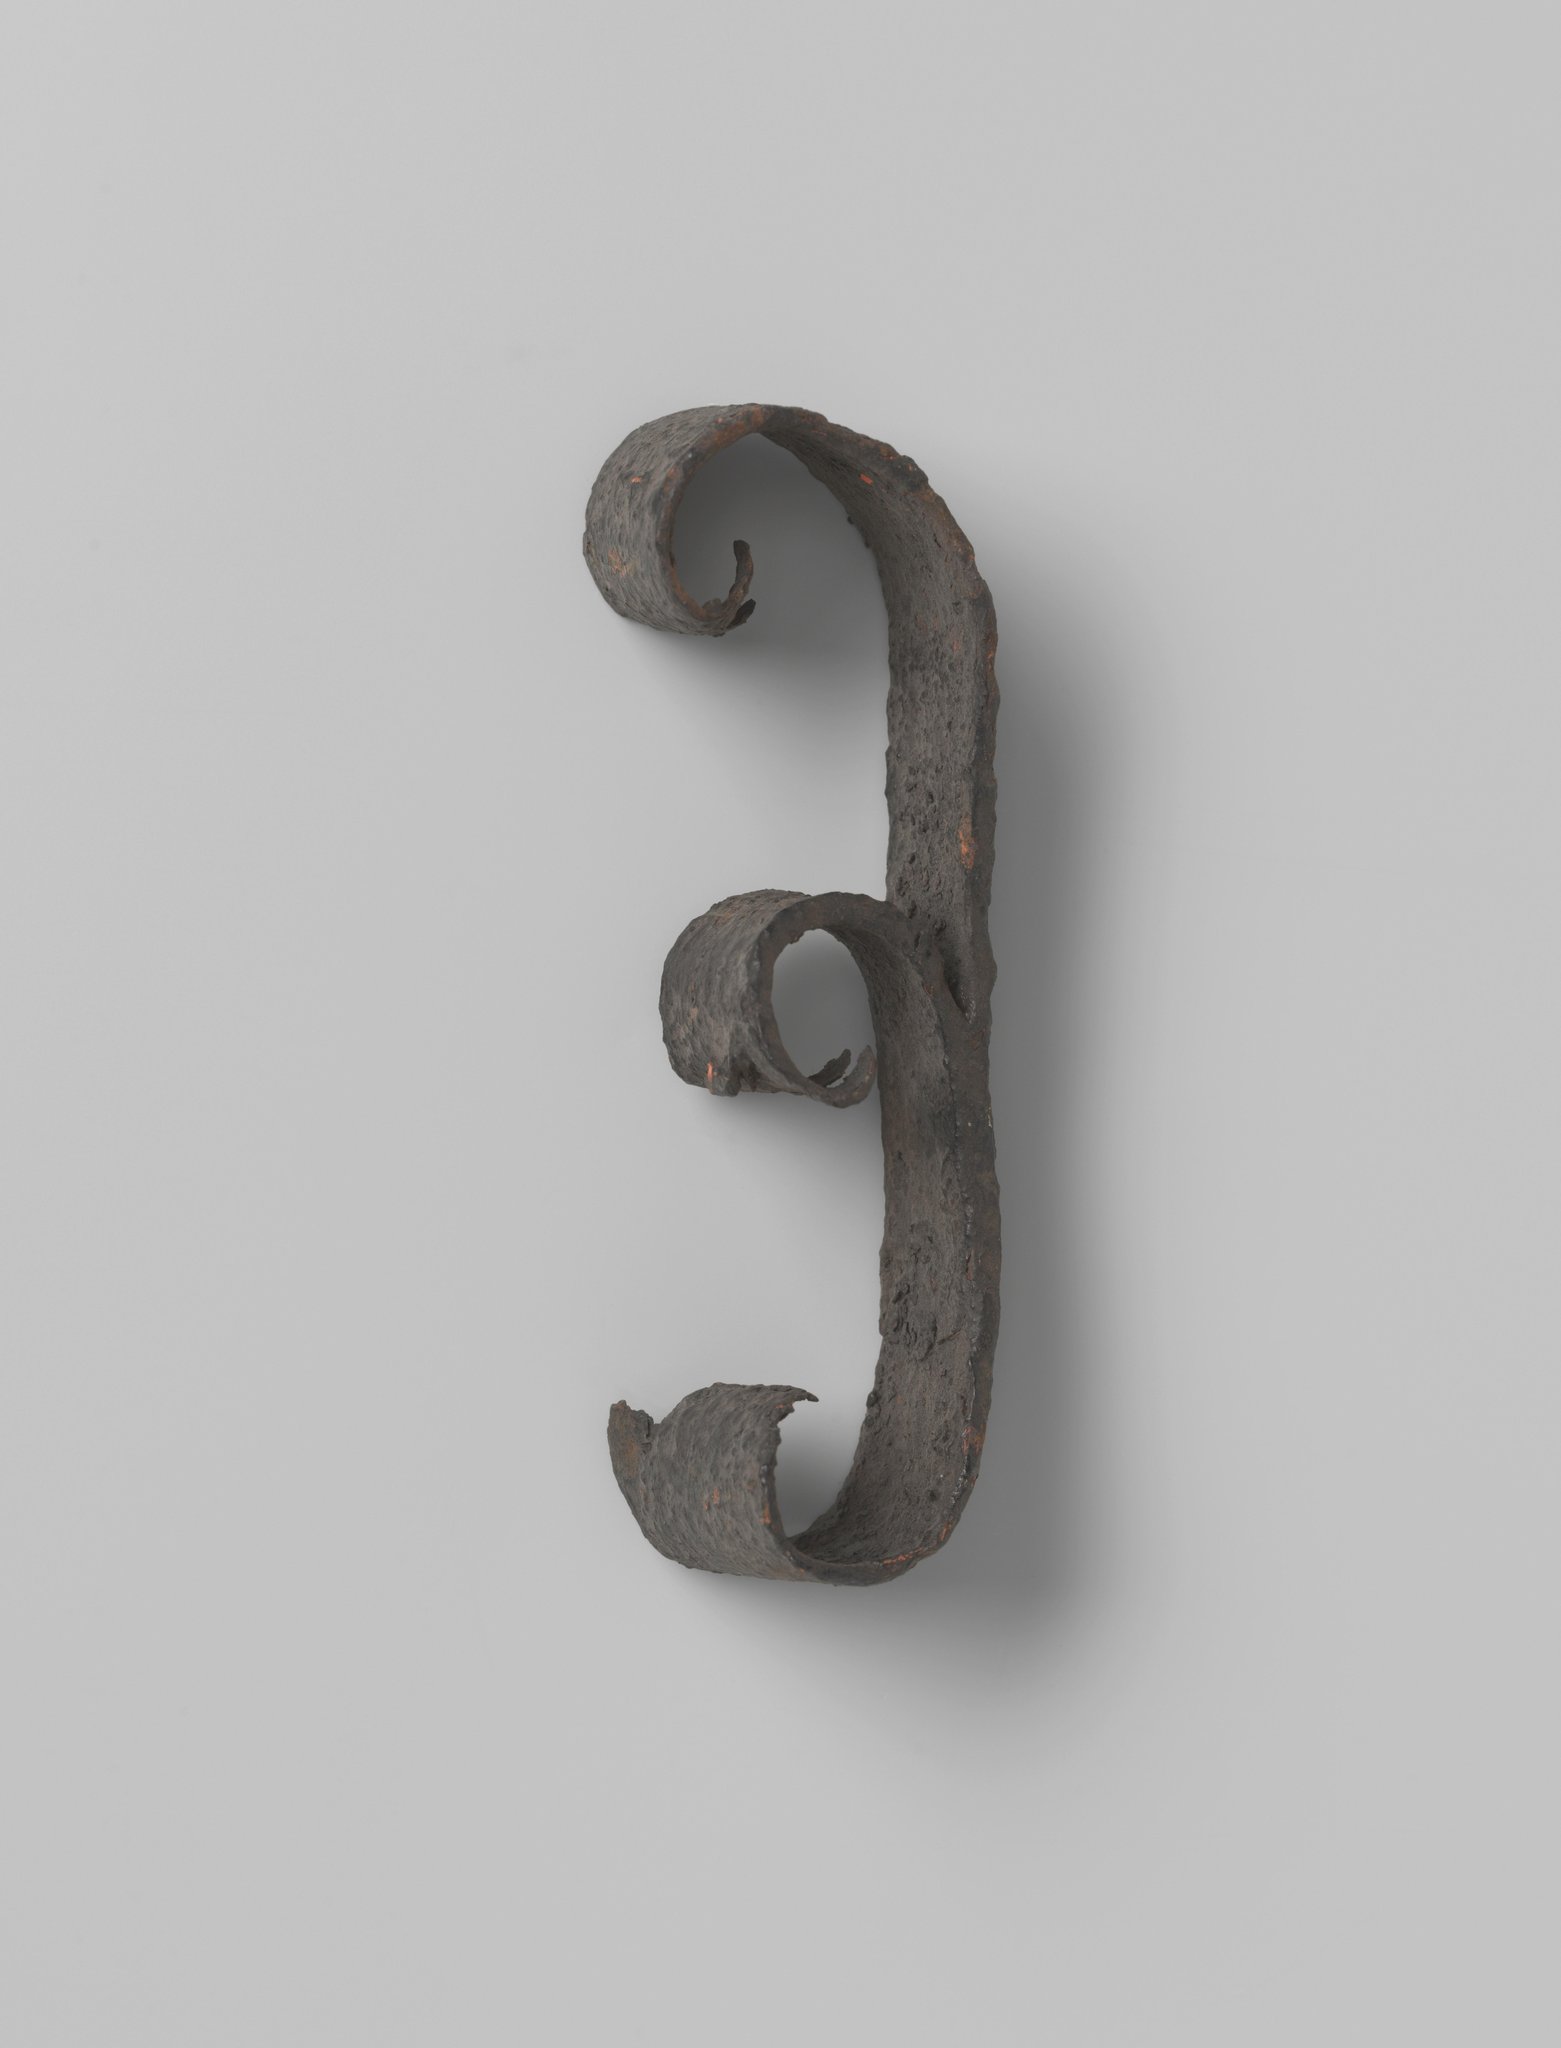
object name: torenkruis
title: Scharnier behorend bij een torenkruis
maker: Anonymous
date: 1500-1900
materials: iron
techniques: forging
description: Scharnier behorend bij het torenkruis van smeedijzer, uitgevoerd in laat-gotische stijl. Afkomstig uit Zeeland.